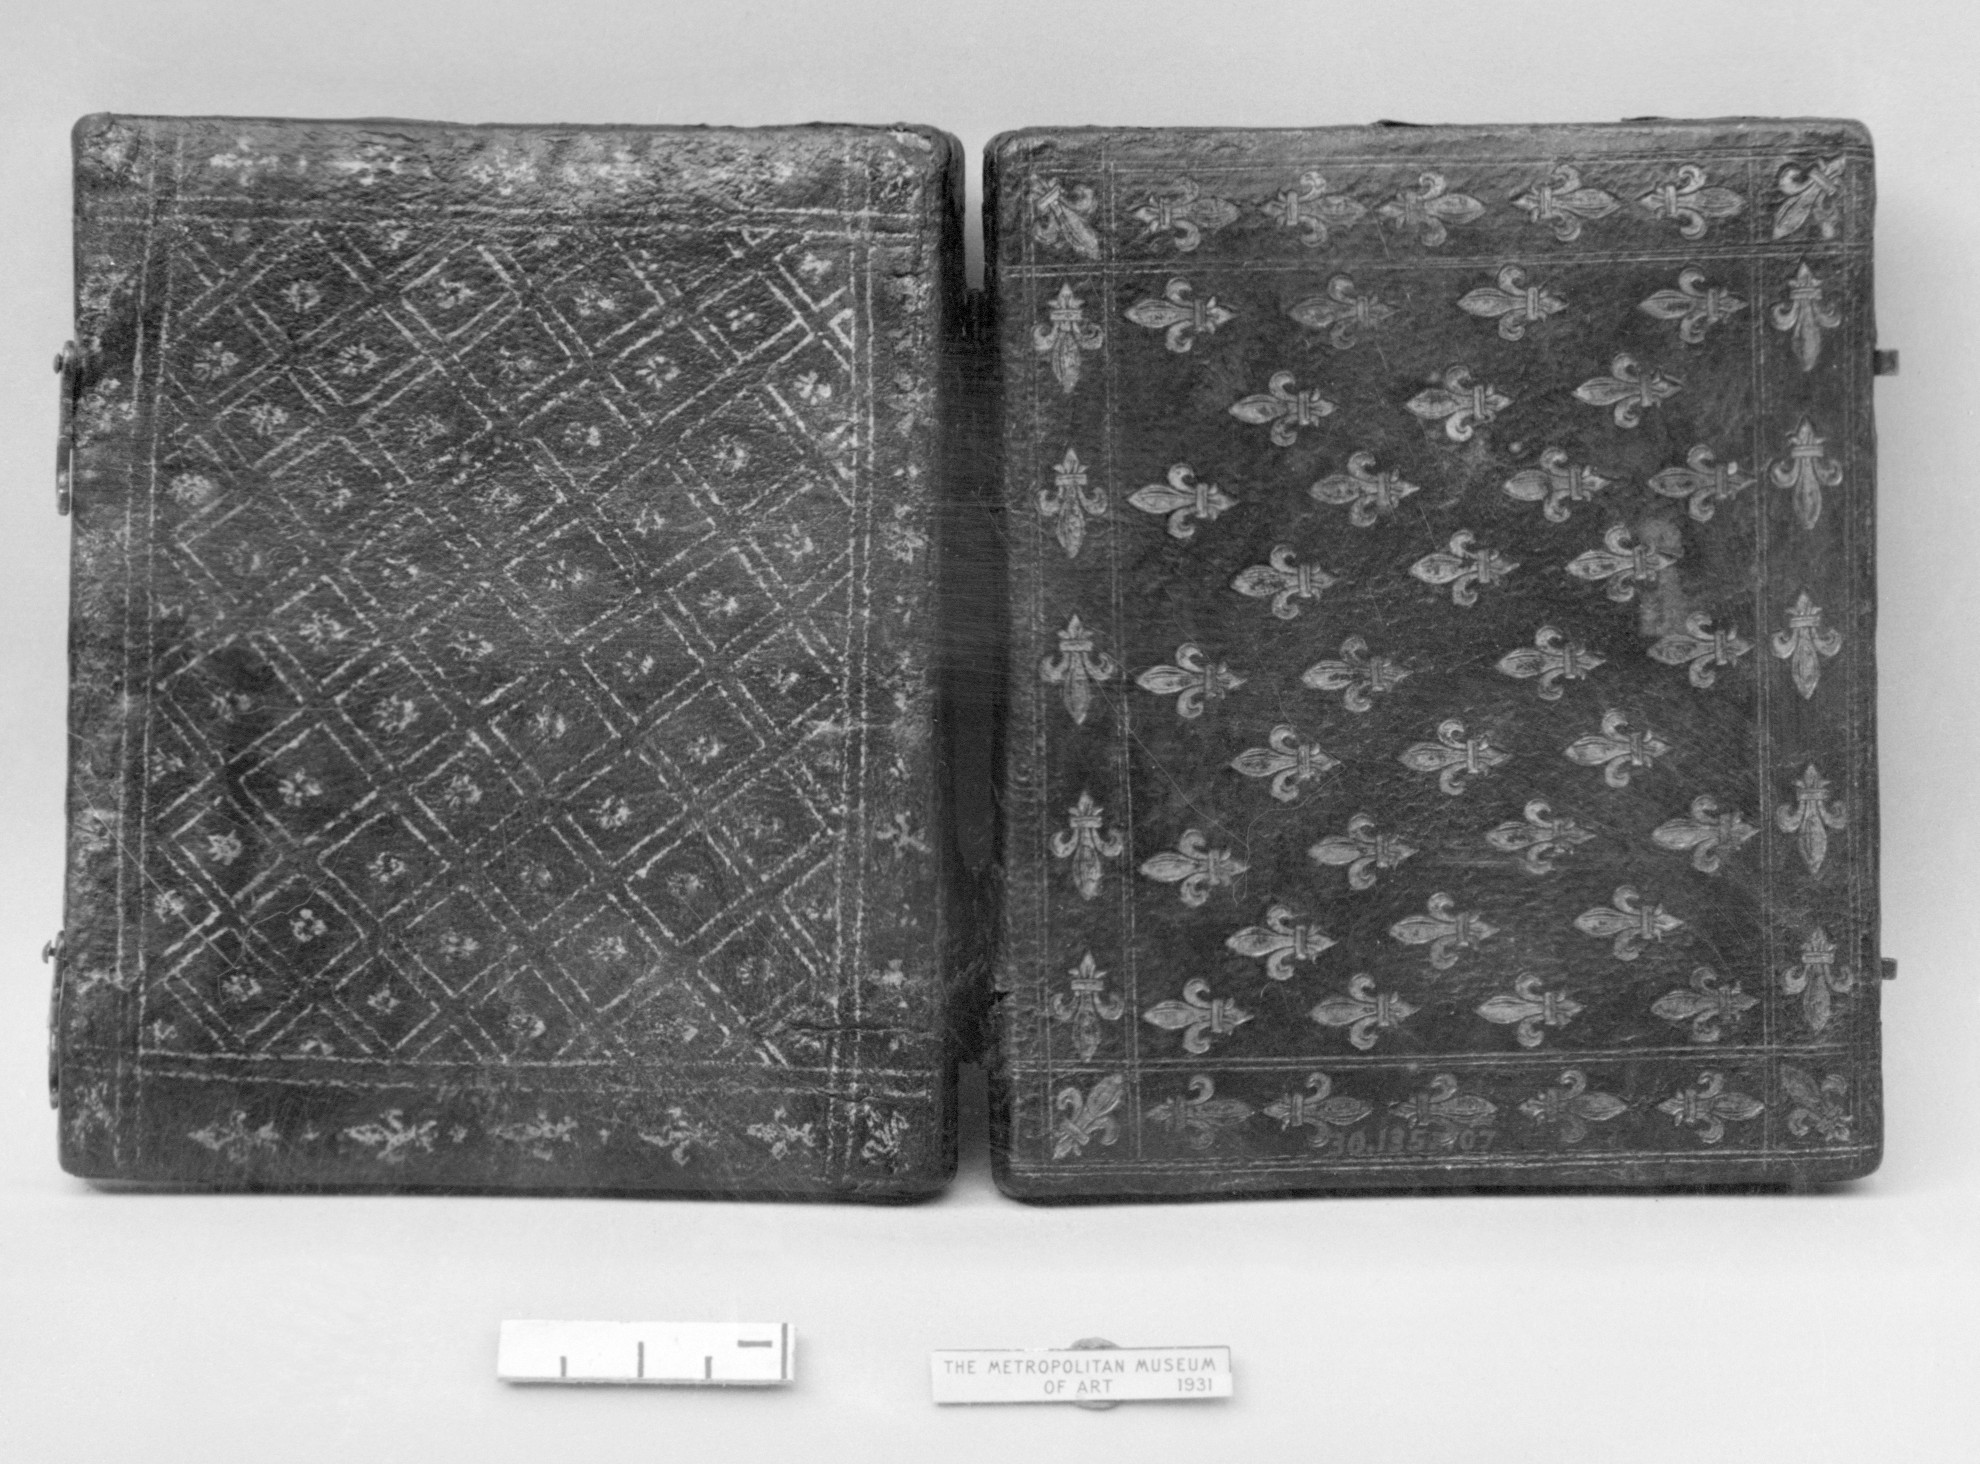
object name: box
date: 1501-1600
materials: gilt, leather, velvet